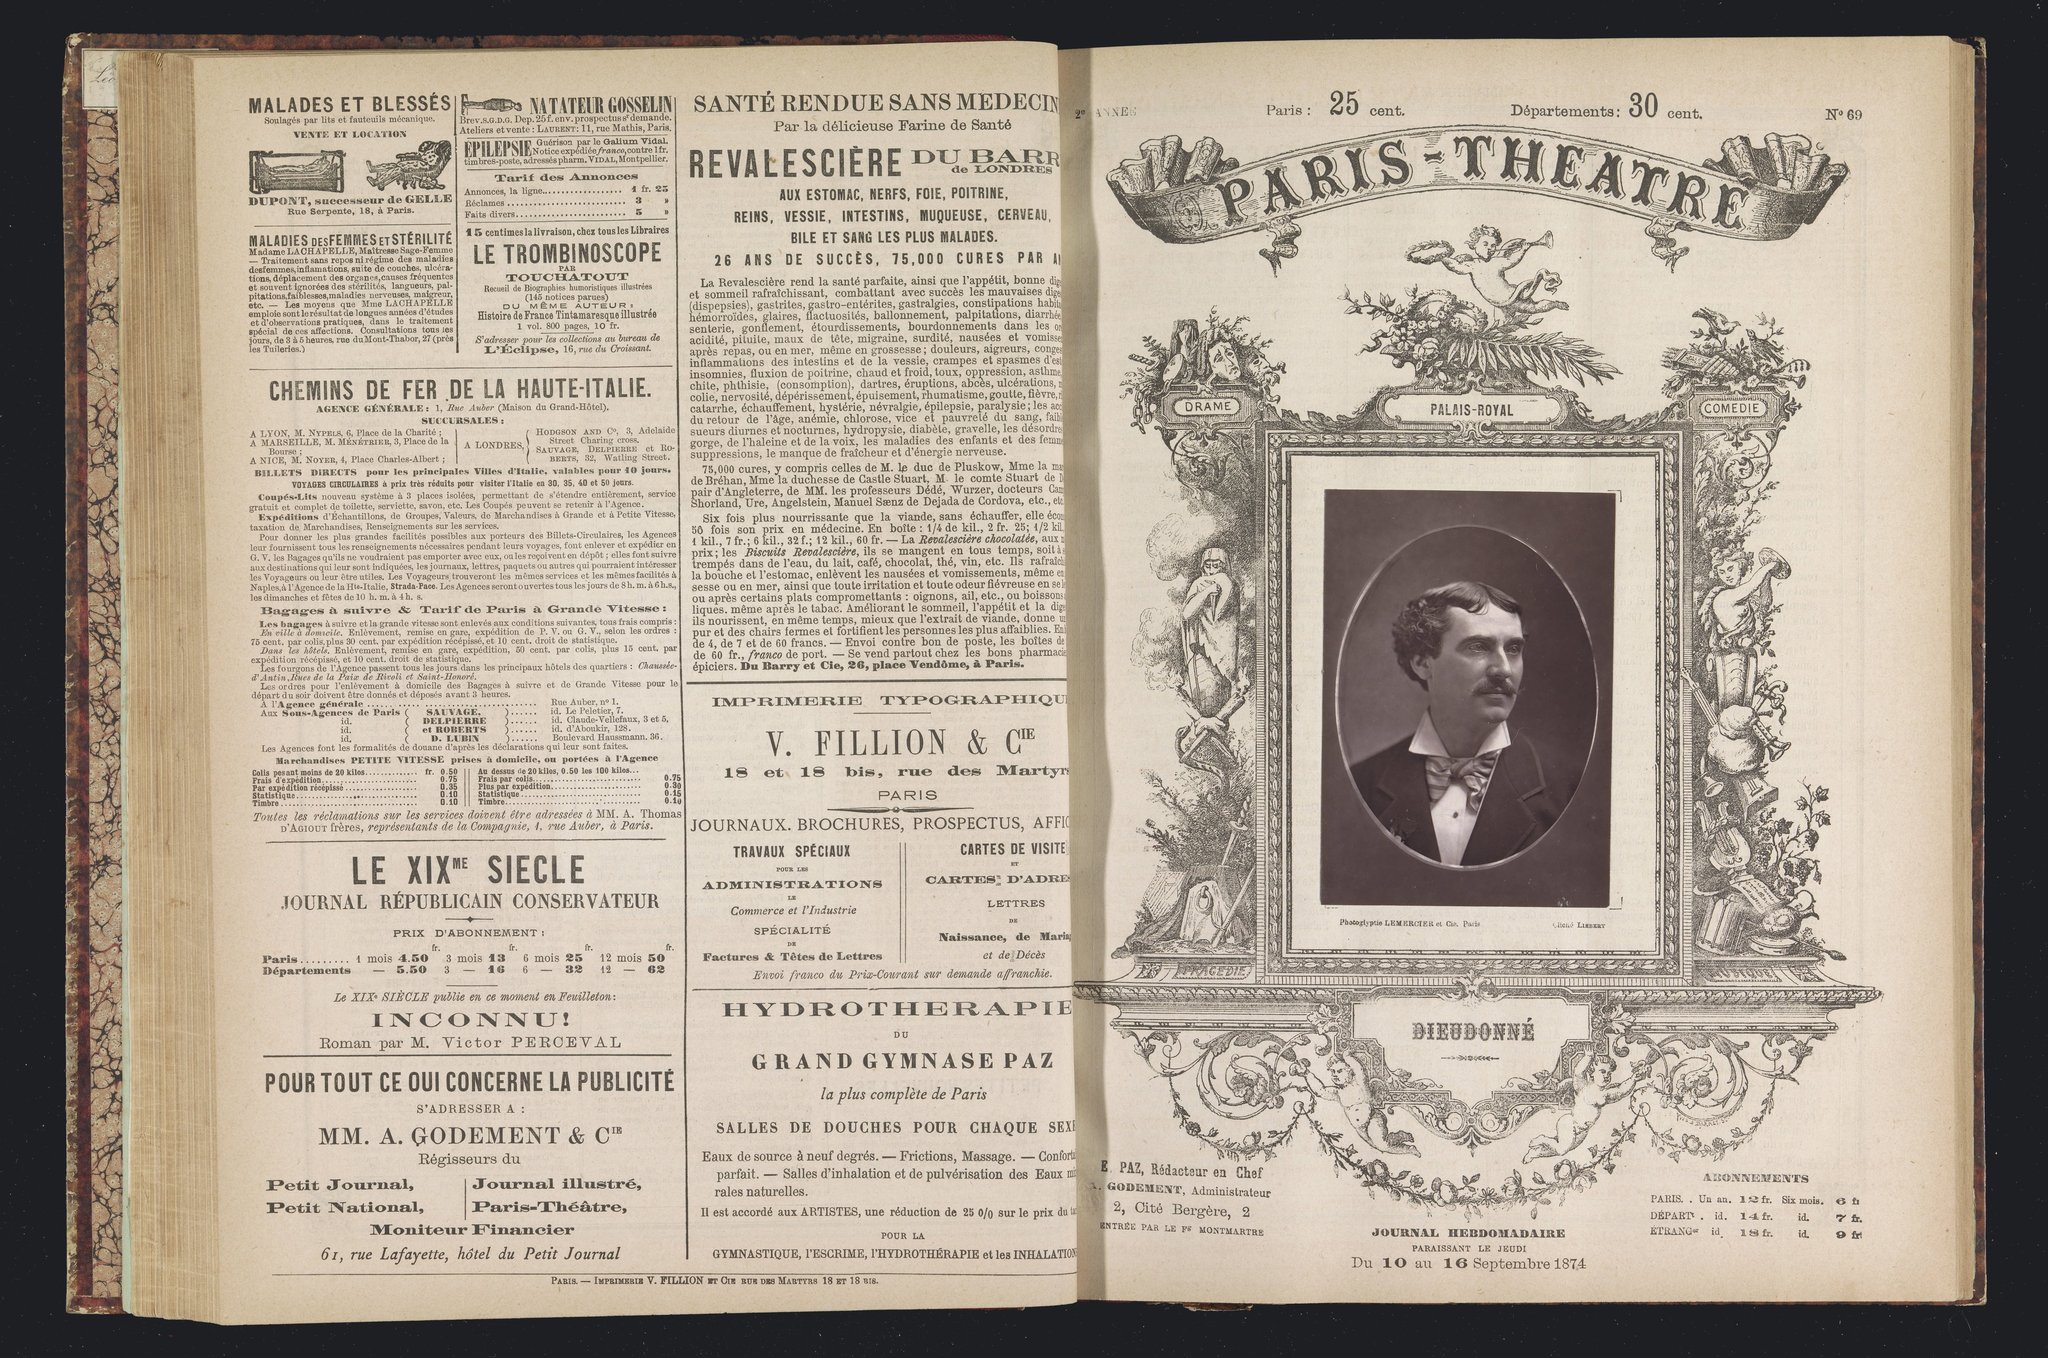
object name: page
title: Portret van Alfred Dieudonné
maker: alphonse-justin liébert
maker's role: fotograaf, marinier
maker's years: 1827-1914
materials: paper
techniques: woodburytype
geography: france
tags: portrait of actor, actress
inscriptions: number: ‘No 69’, inscription: ‘Journal hebdomadaire paraissant le jeudi Du 10 au 16 Septembre 1874’